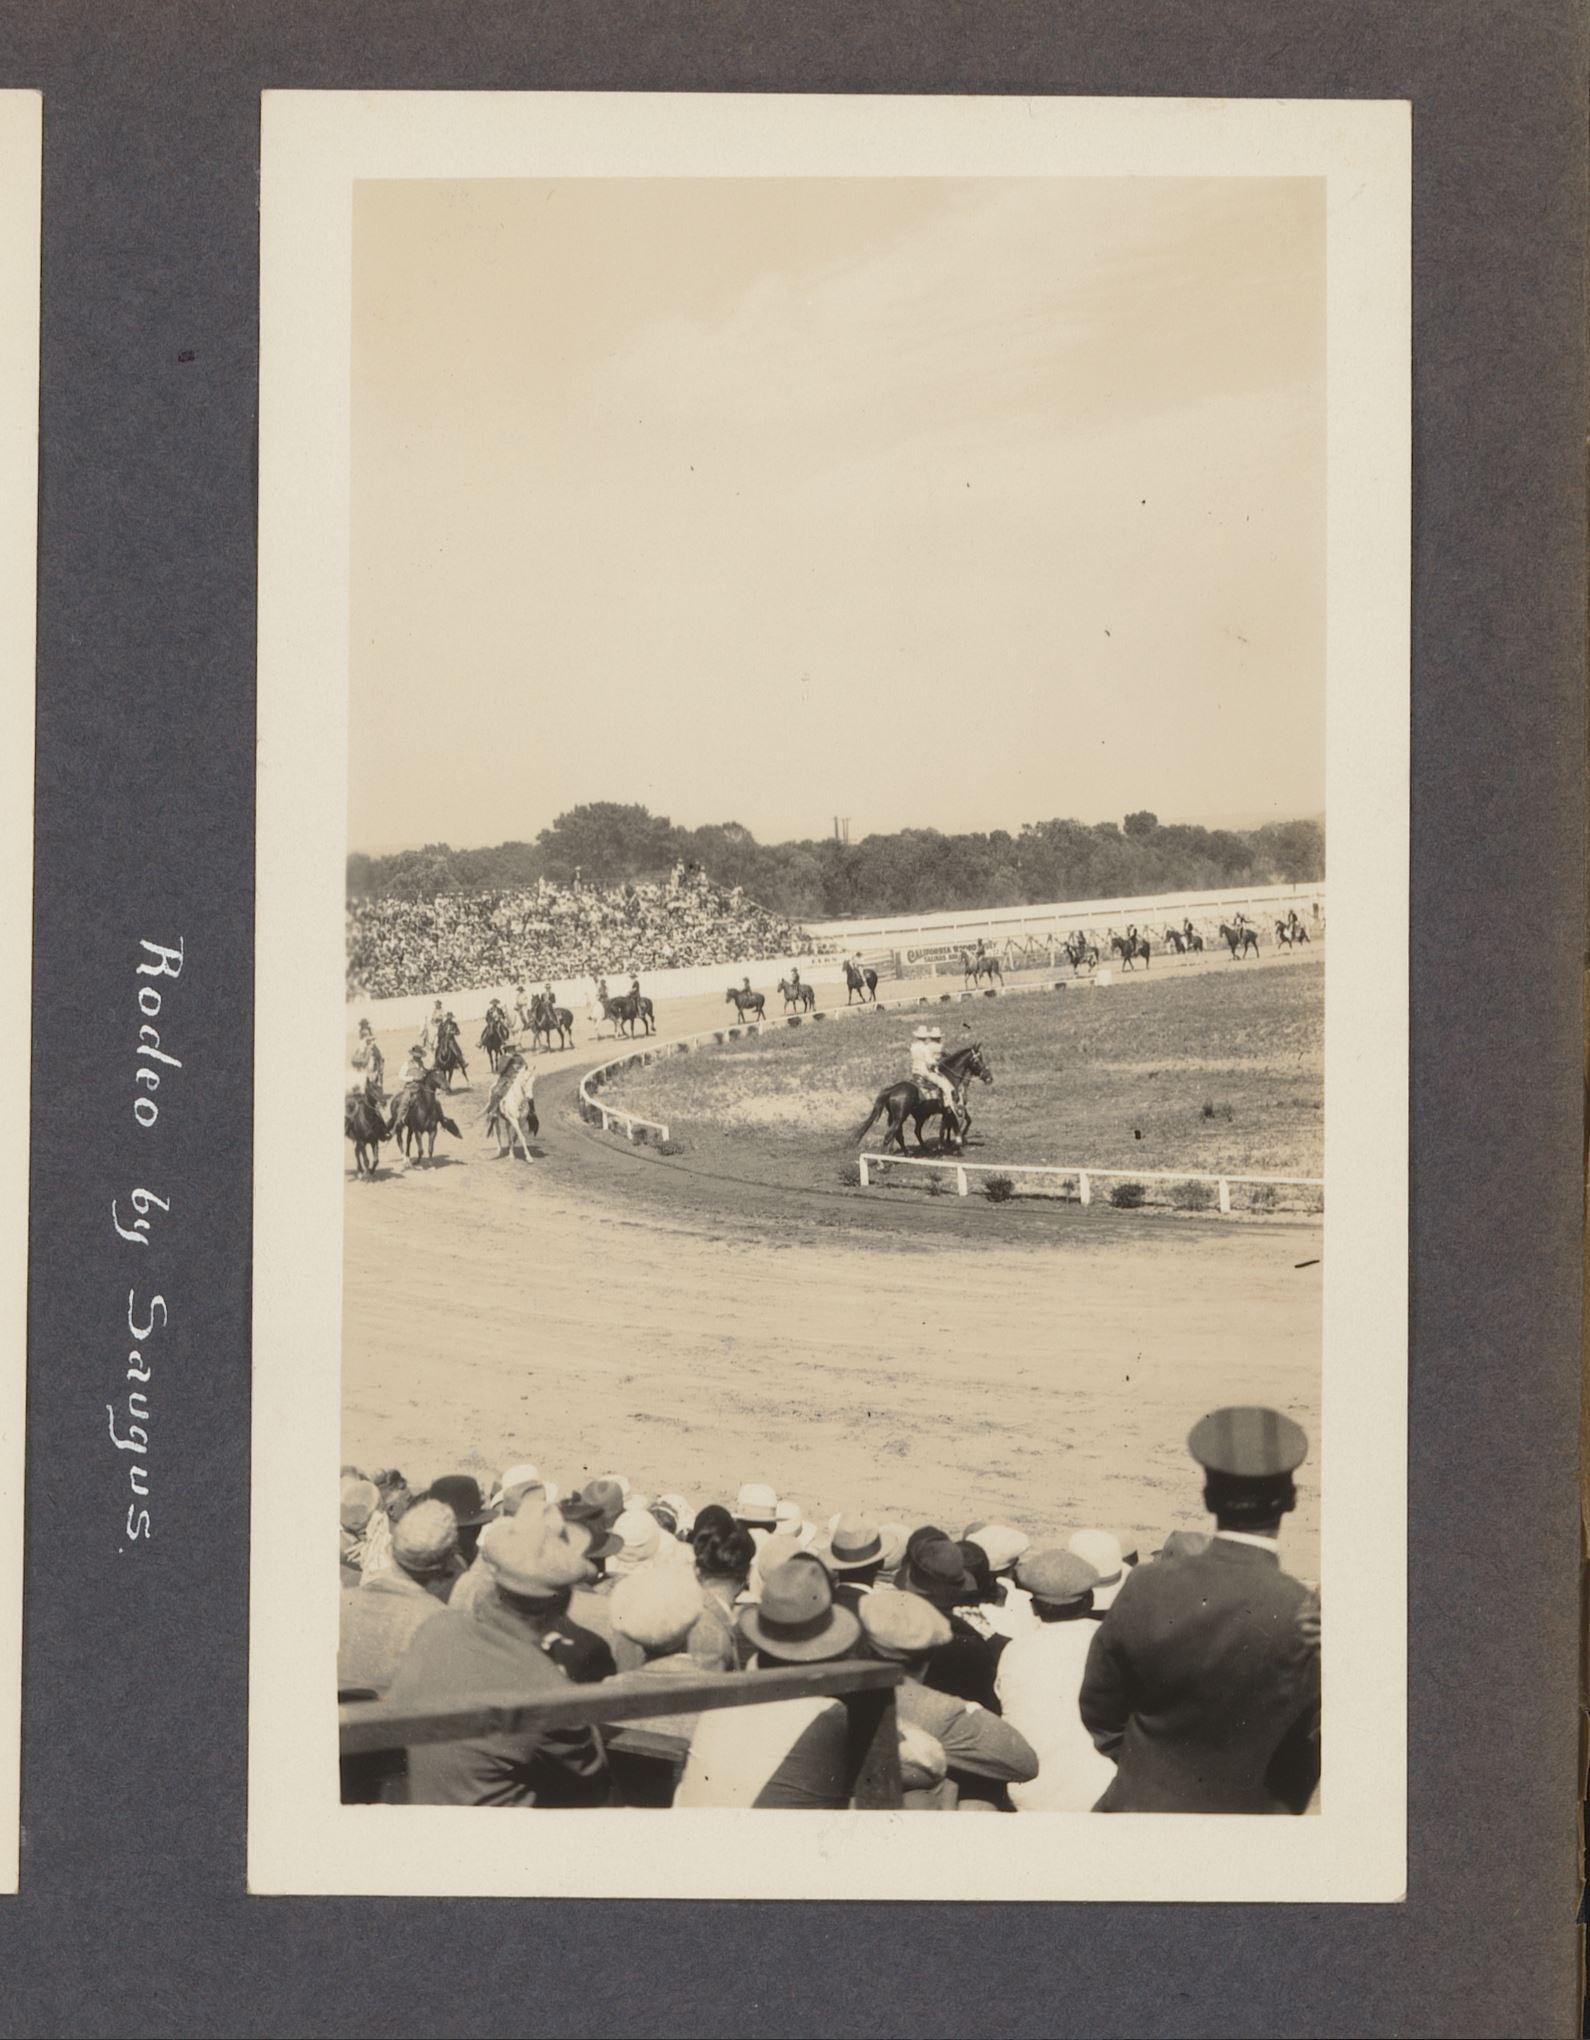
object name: album leaf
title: Rodeo bij Baker Ranch in de omgeving van Saugus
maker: Anonymous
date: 1928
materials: photographic support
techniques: gelatin silver print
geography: saugus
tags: historical persons, the audience ~ art performance, rodeo, horse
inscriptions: annotation: ‘Rodeo bij Saugus’